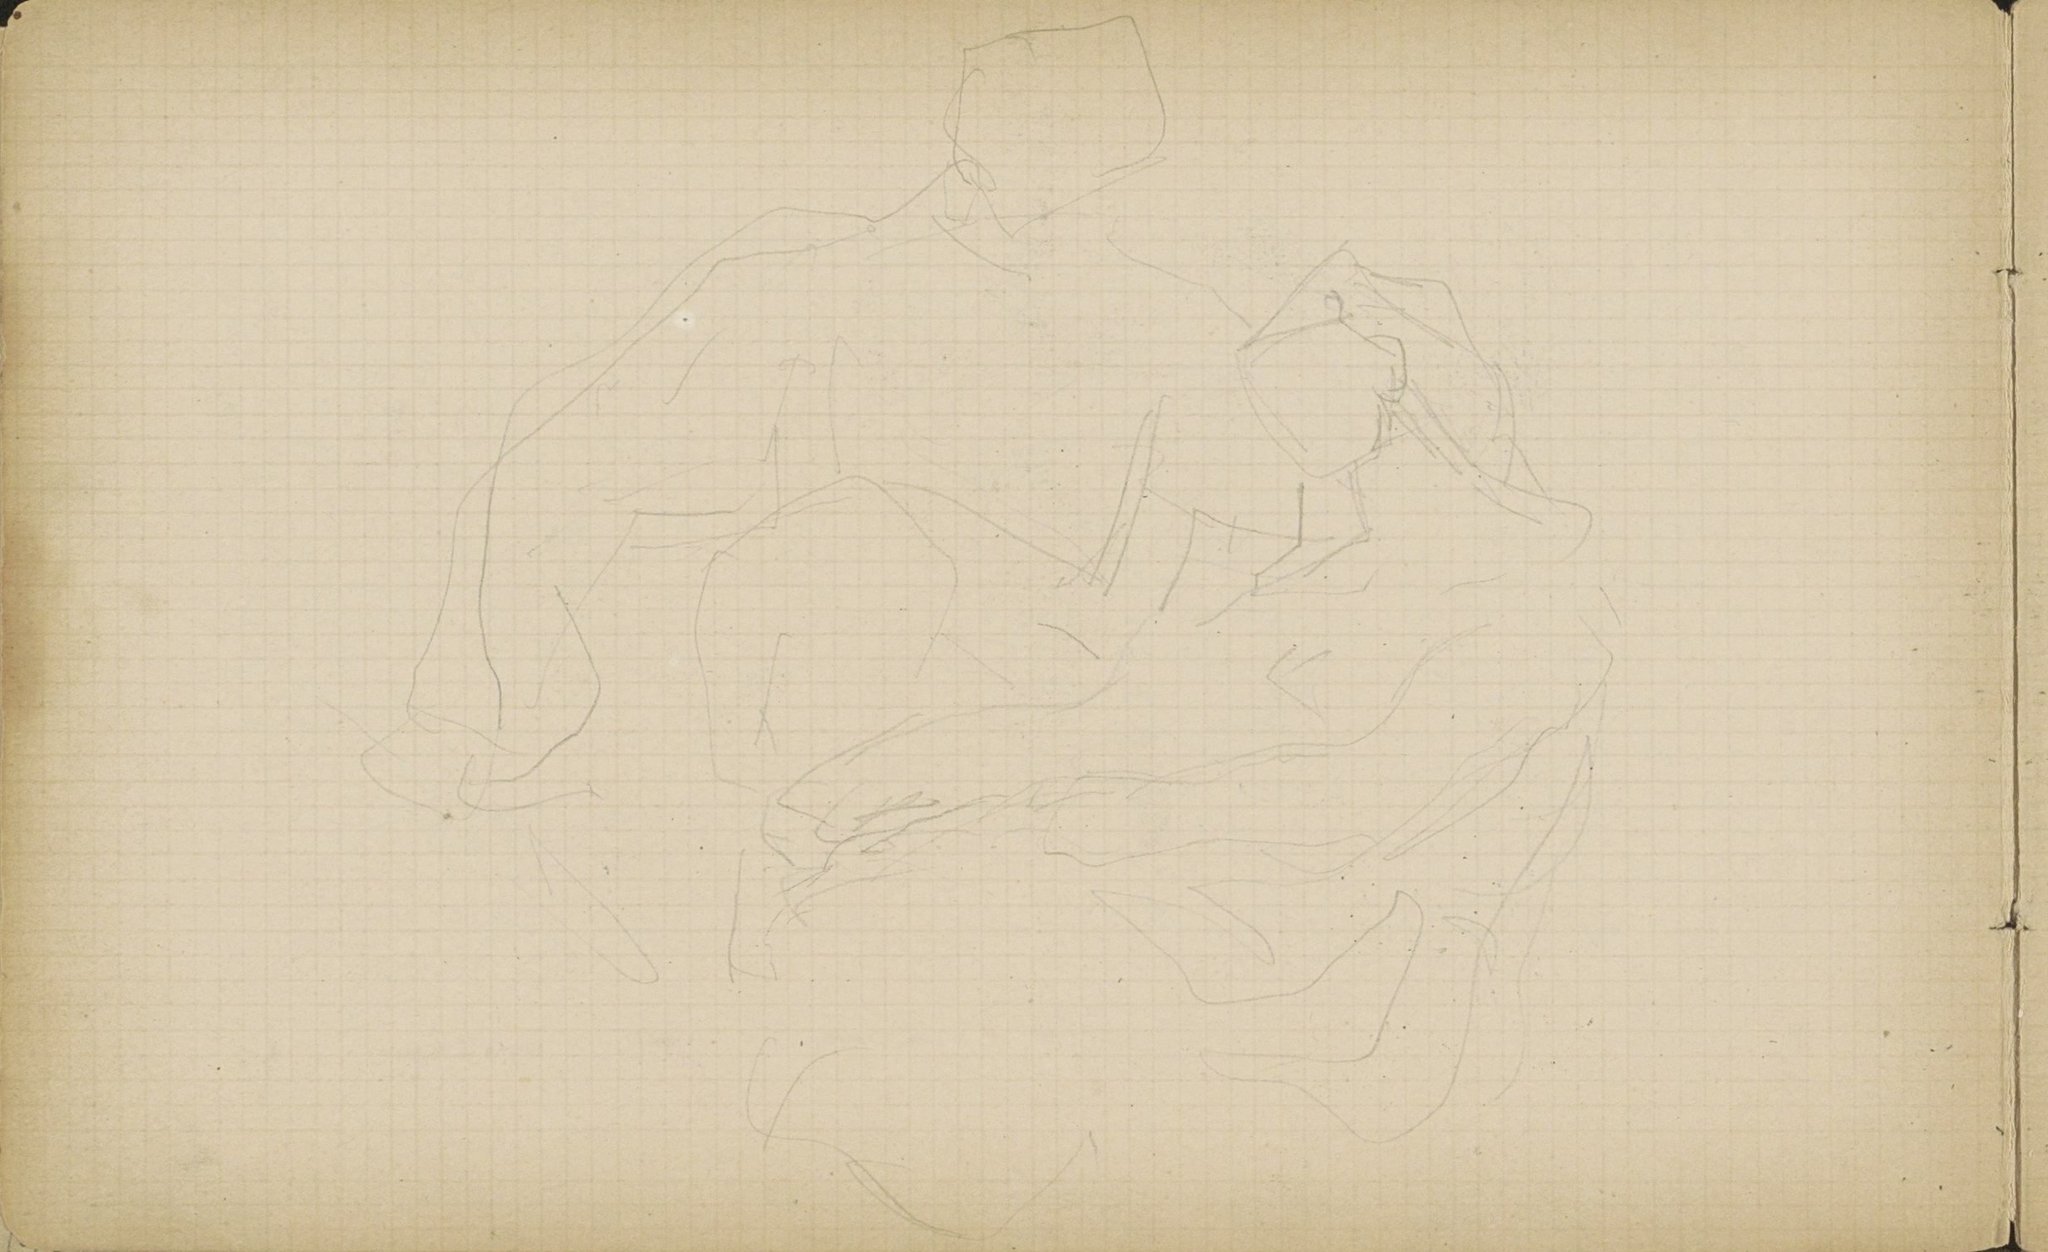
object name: sketchbook leaf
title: Knielende man bij een liggende vrouw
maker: matthijs maris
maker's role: draughtsman, painter, print maker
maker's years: 1839-1917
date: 1849-1917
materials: pencil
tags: kneeling figure (+ male human being (not to be used where -a- is prescribed)), lying figure (+ female (human being) (not to be used where -aa- is prescribed))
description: Blad 1 verso uit een schetsboek met 35 bladen.